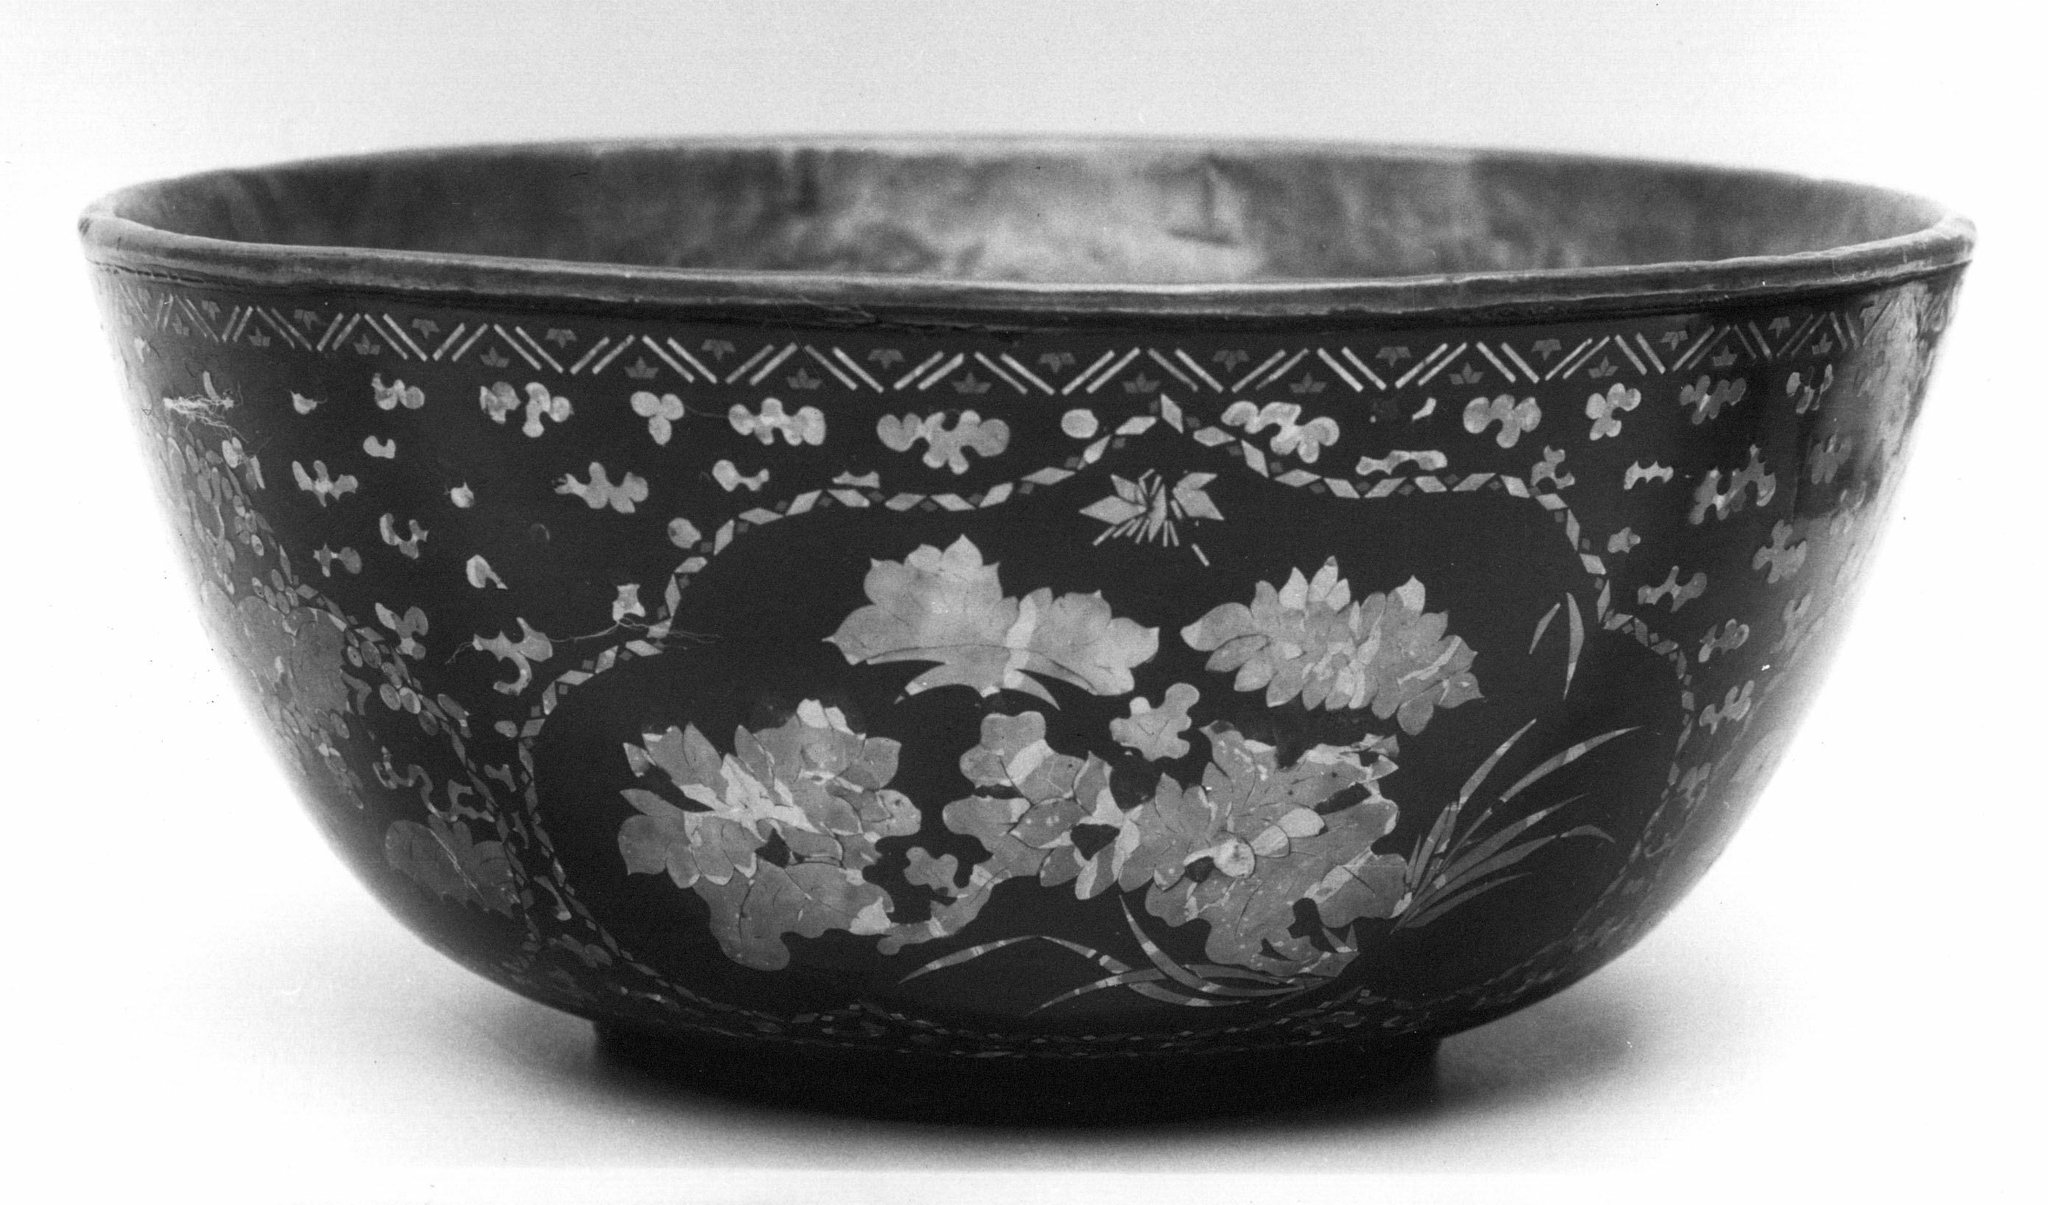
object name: bowl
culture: chinese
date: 1601-1700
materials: lacquer, pewter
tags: insects